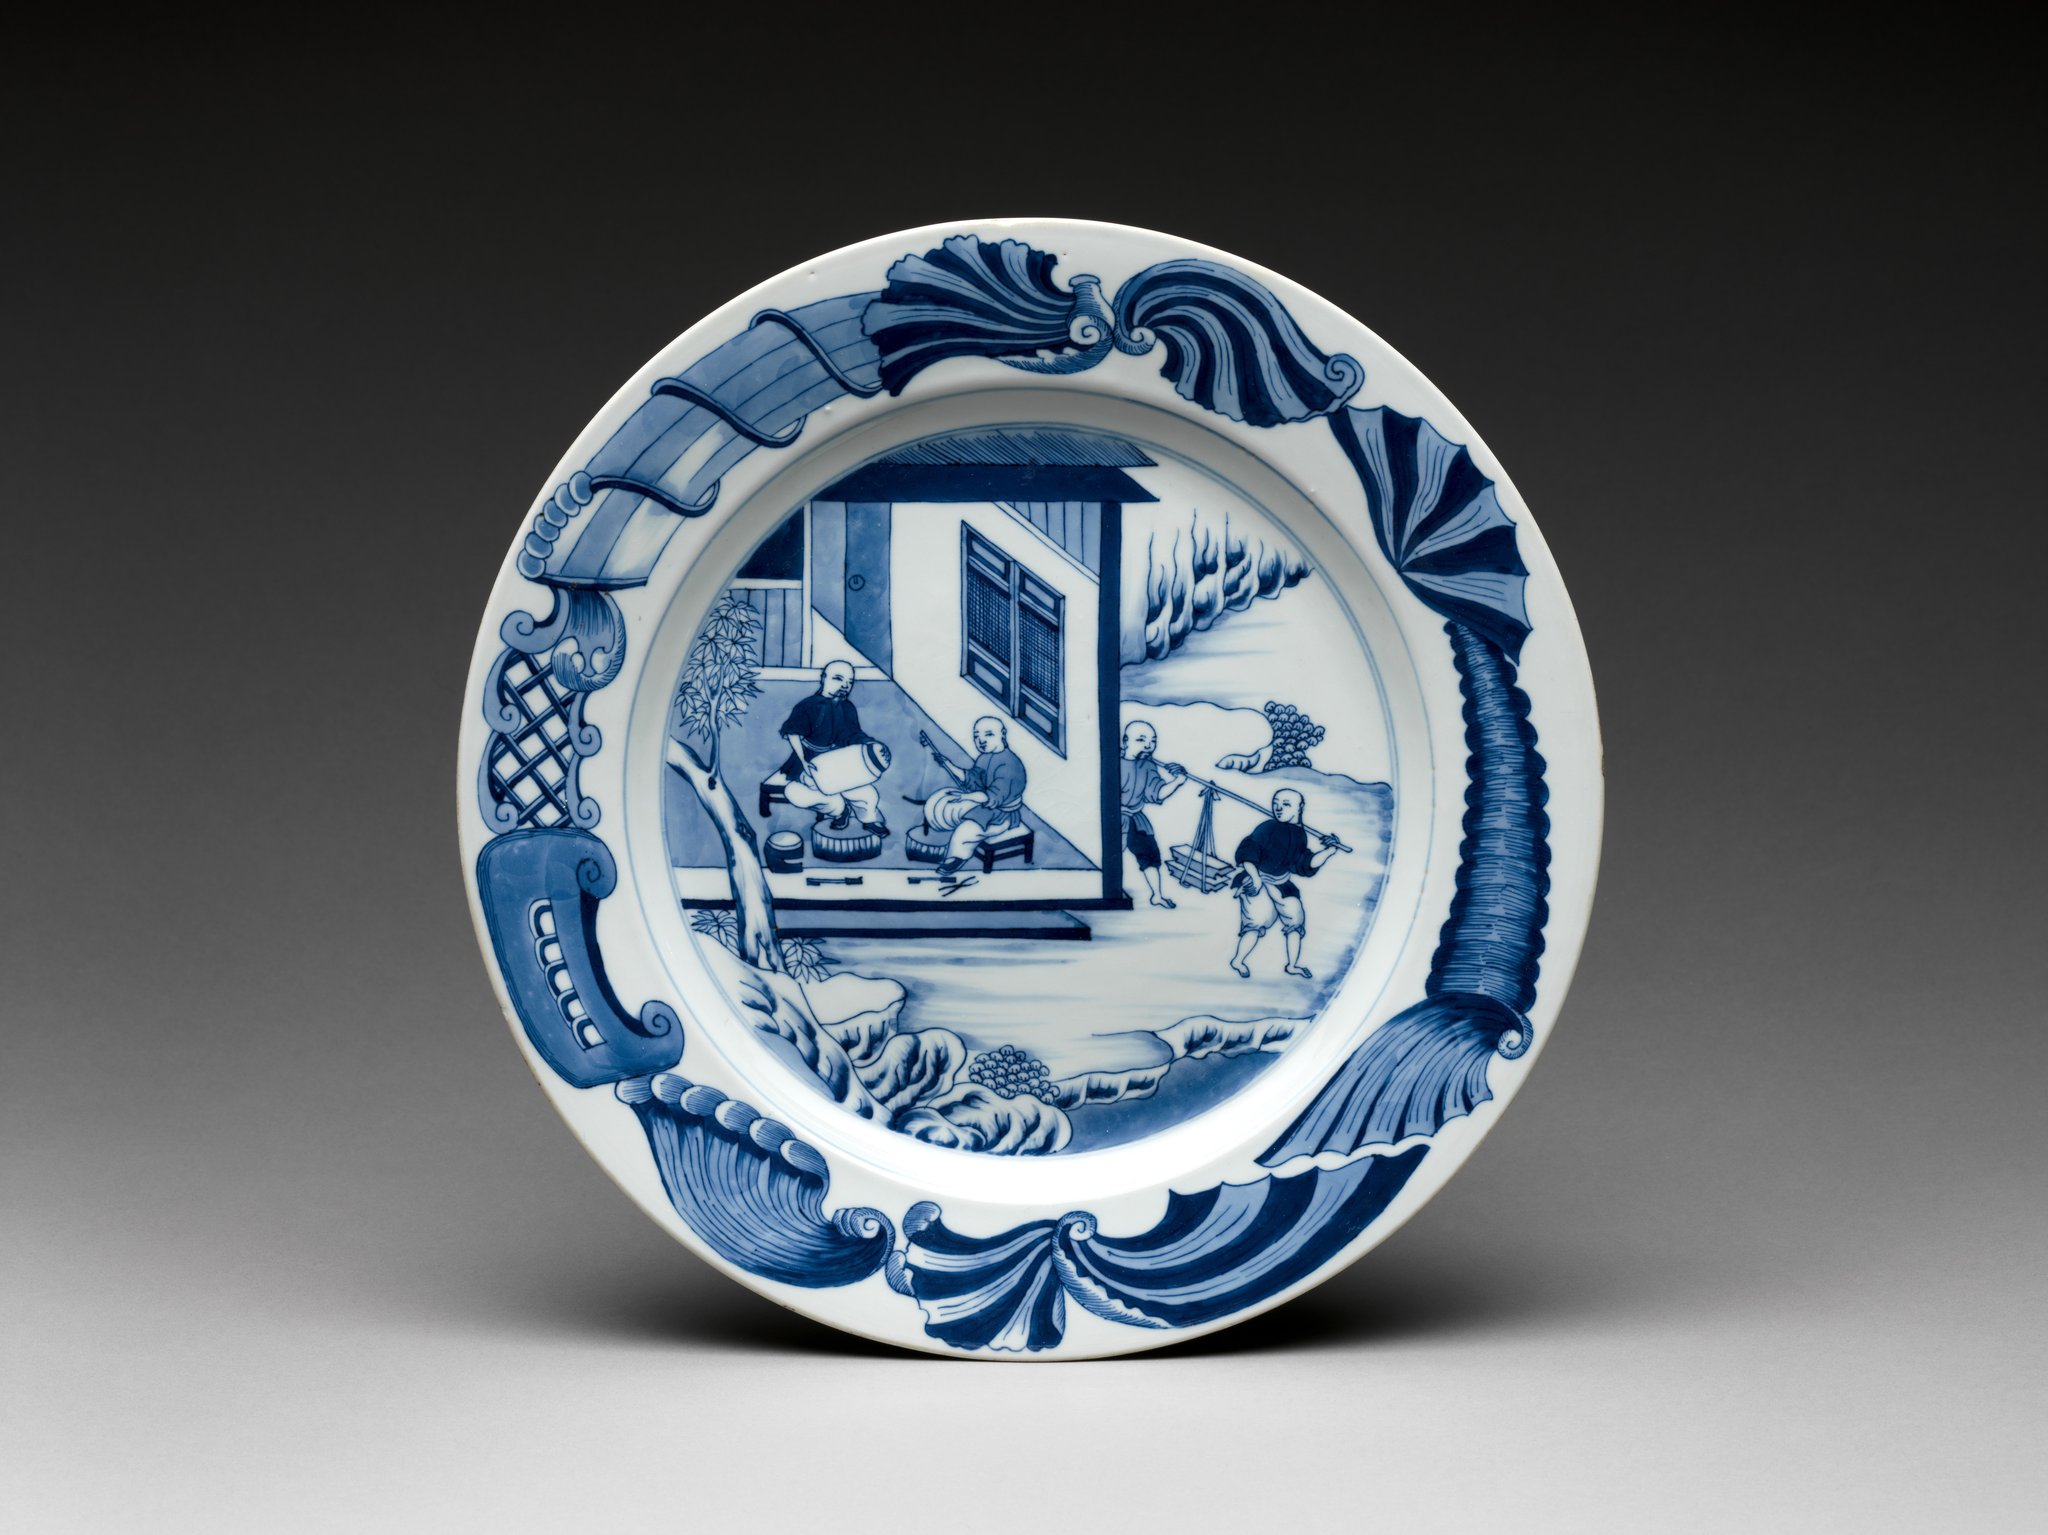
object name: dish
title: Dish with a scene of tea cultivation (one of a pair)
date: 1740-1745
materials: cobalt, glaze, hard paste porcelain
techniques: painting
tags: men,working